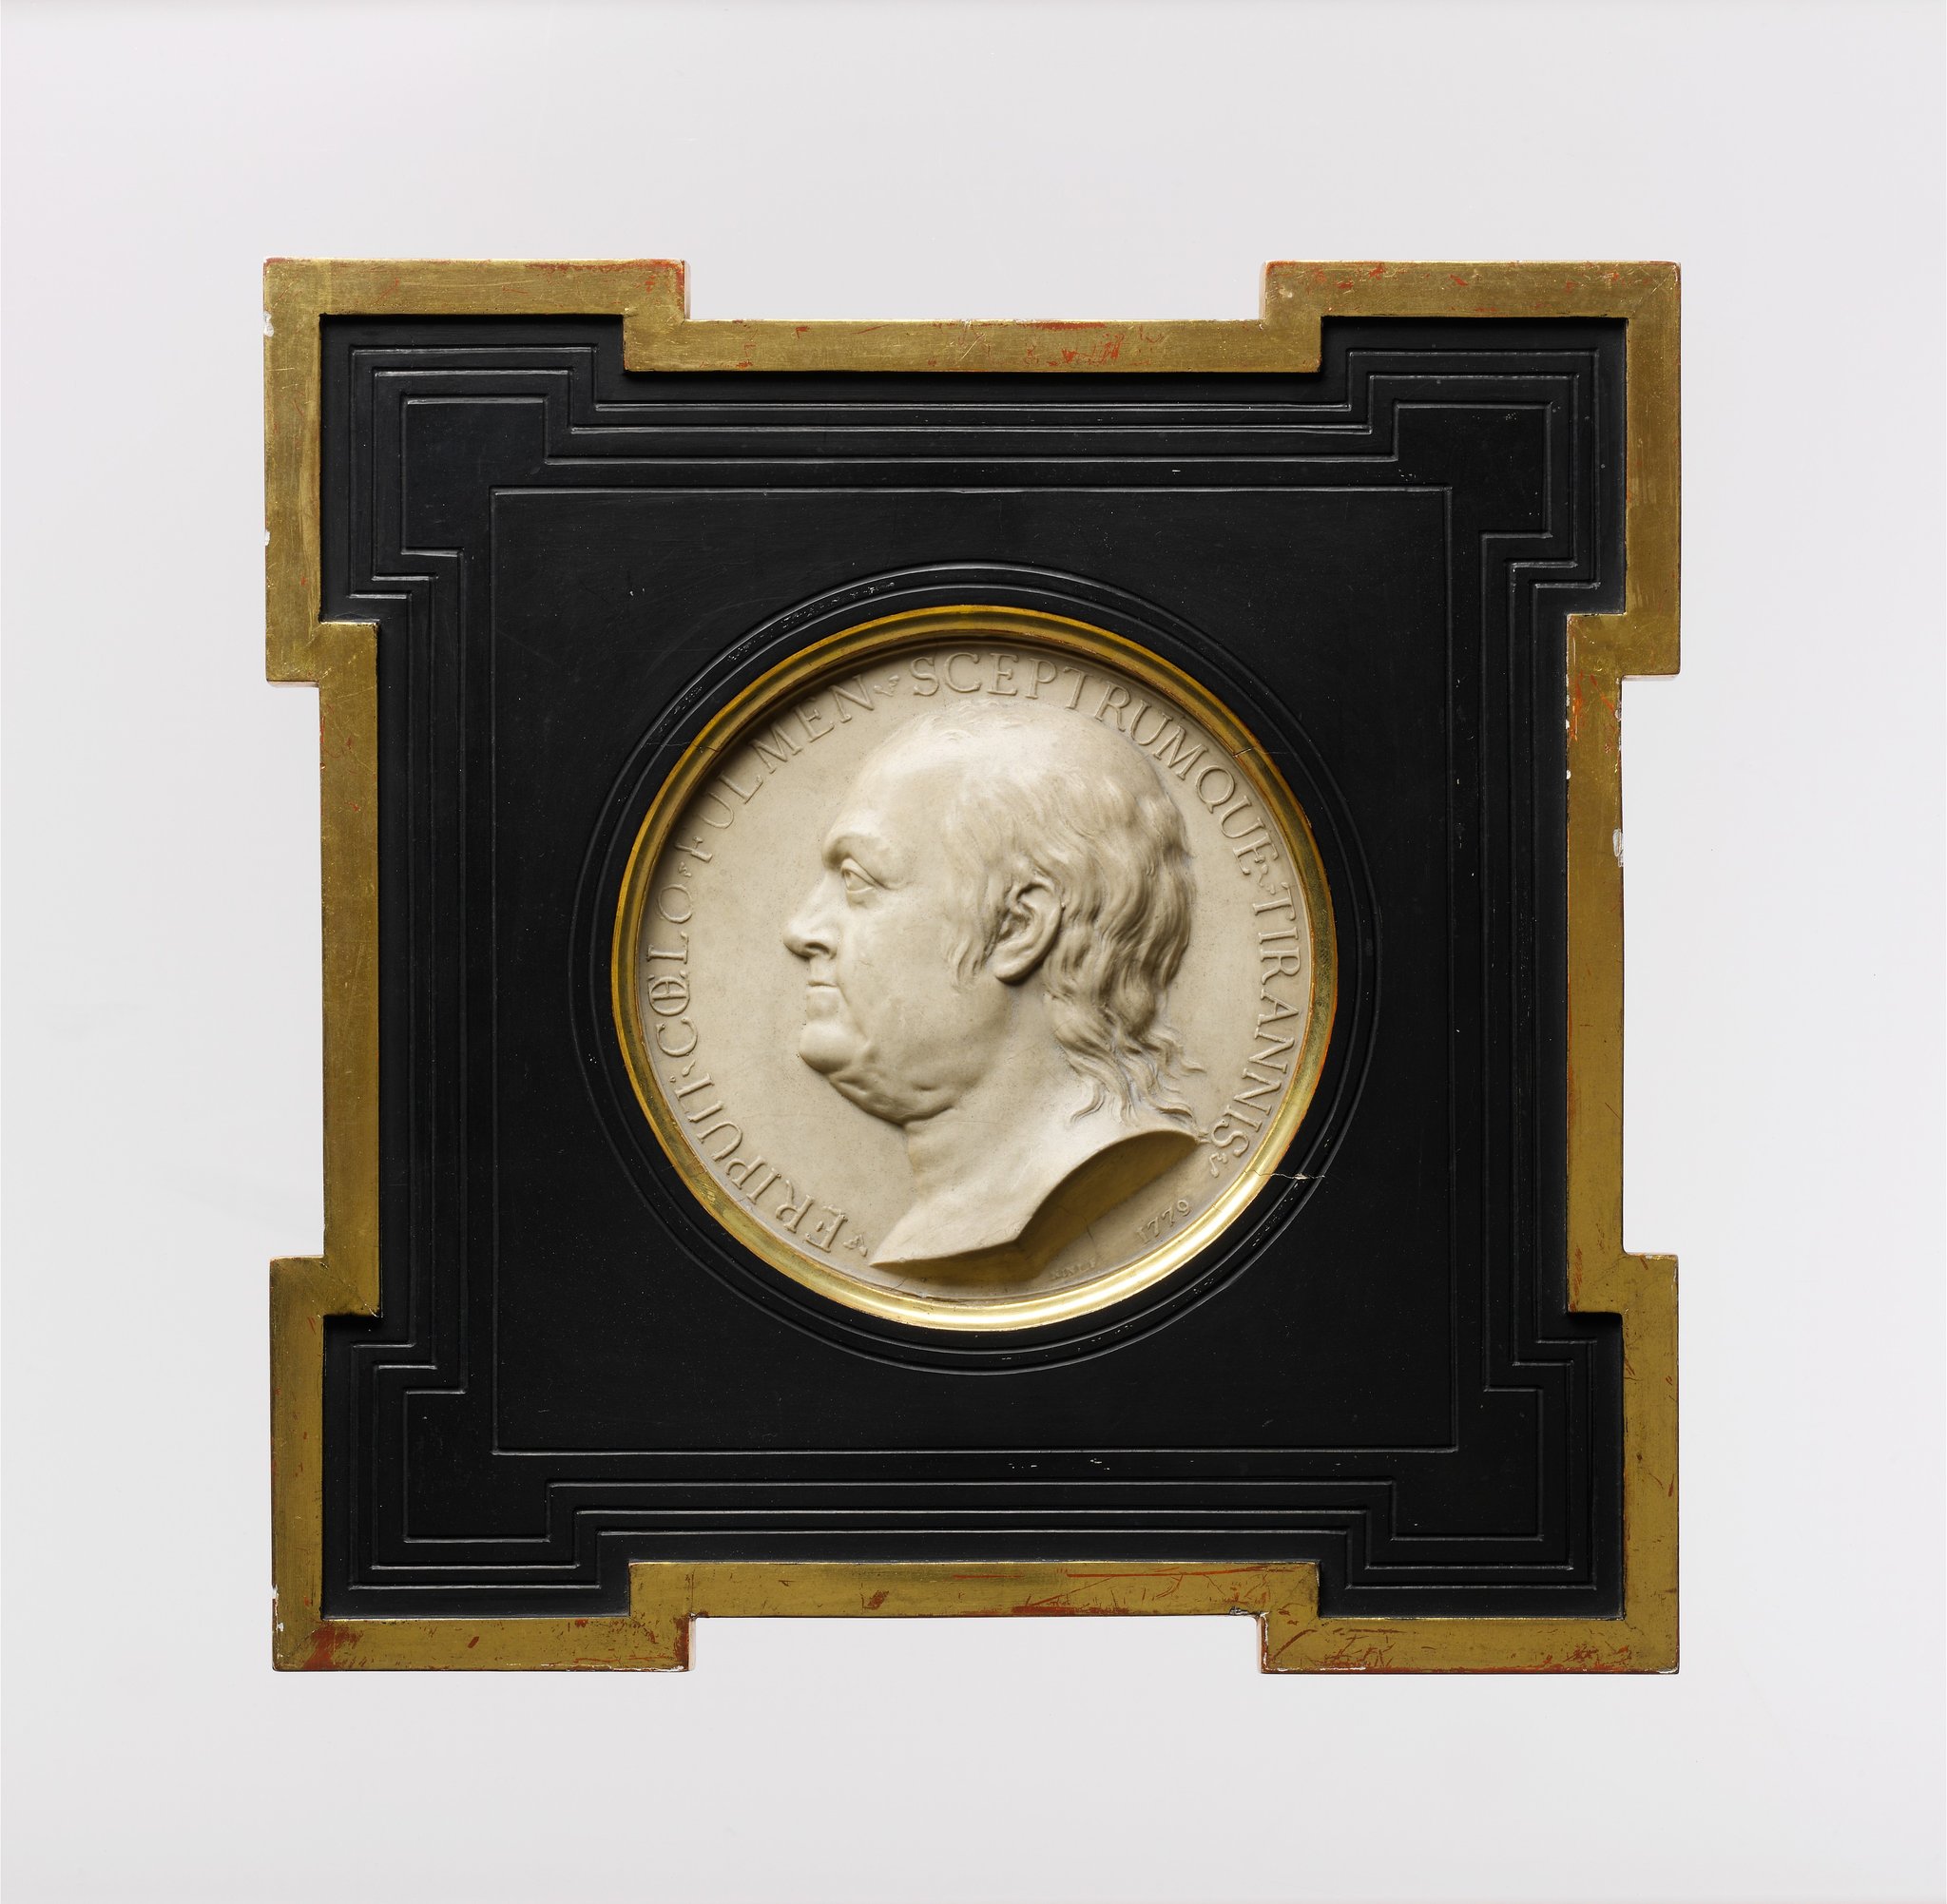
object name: medallion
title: Medallion of Benjamin Franklin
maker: jean-baptiste nini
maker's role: maker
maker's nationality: italian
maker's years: 1717-1786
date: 1779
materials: stoneware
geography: france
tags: benjamin franklin,men,profiles